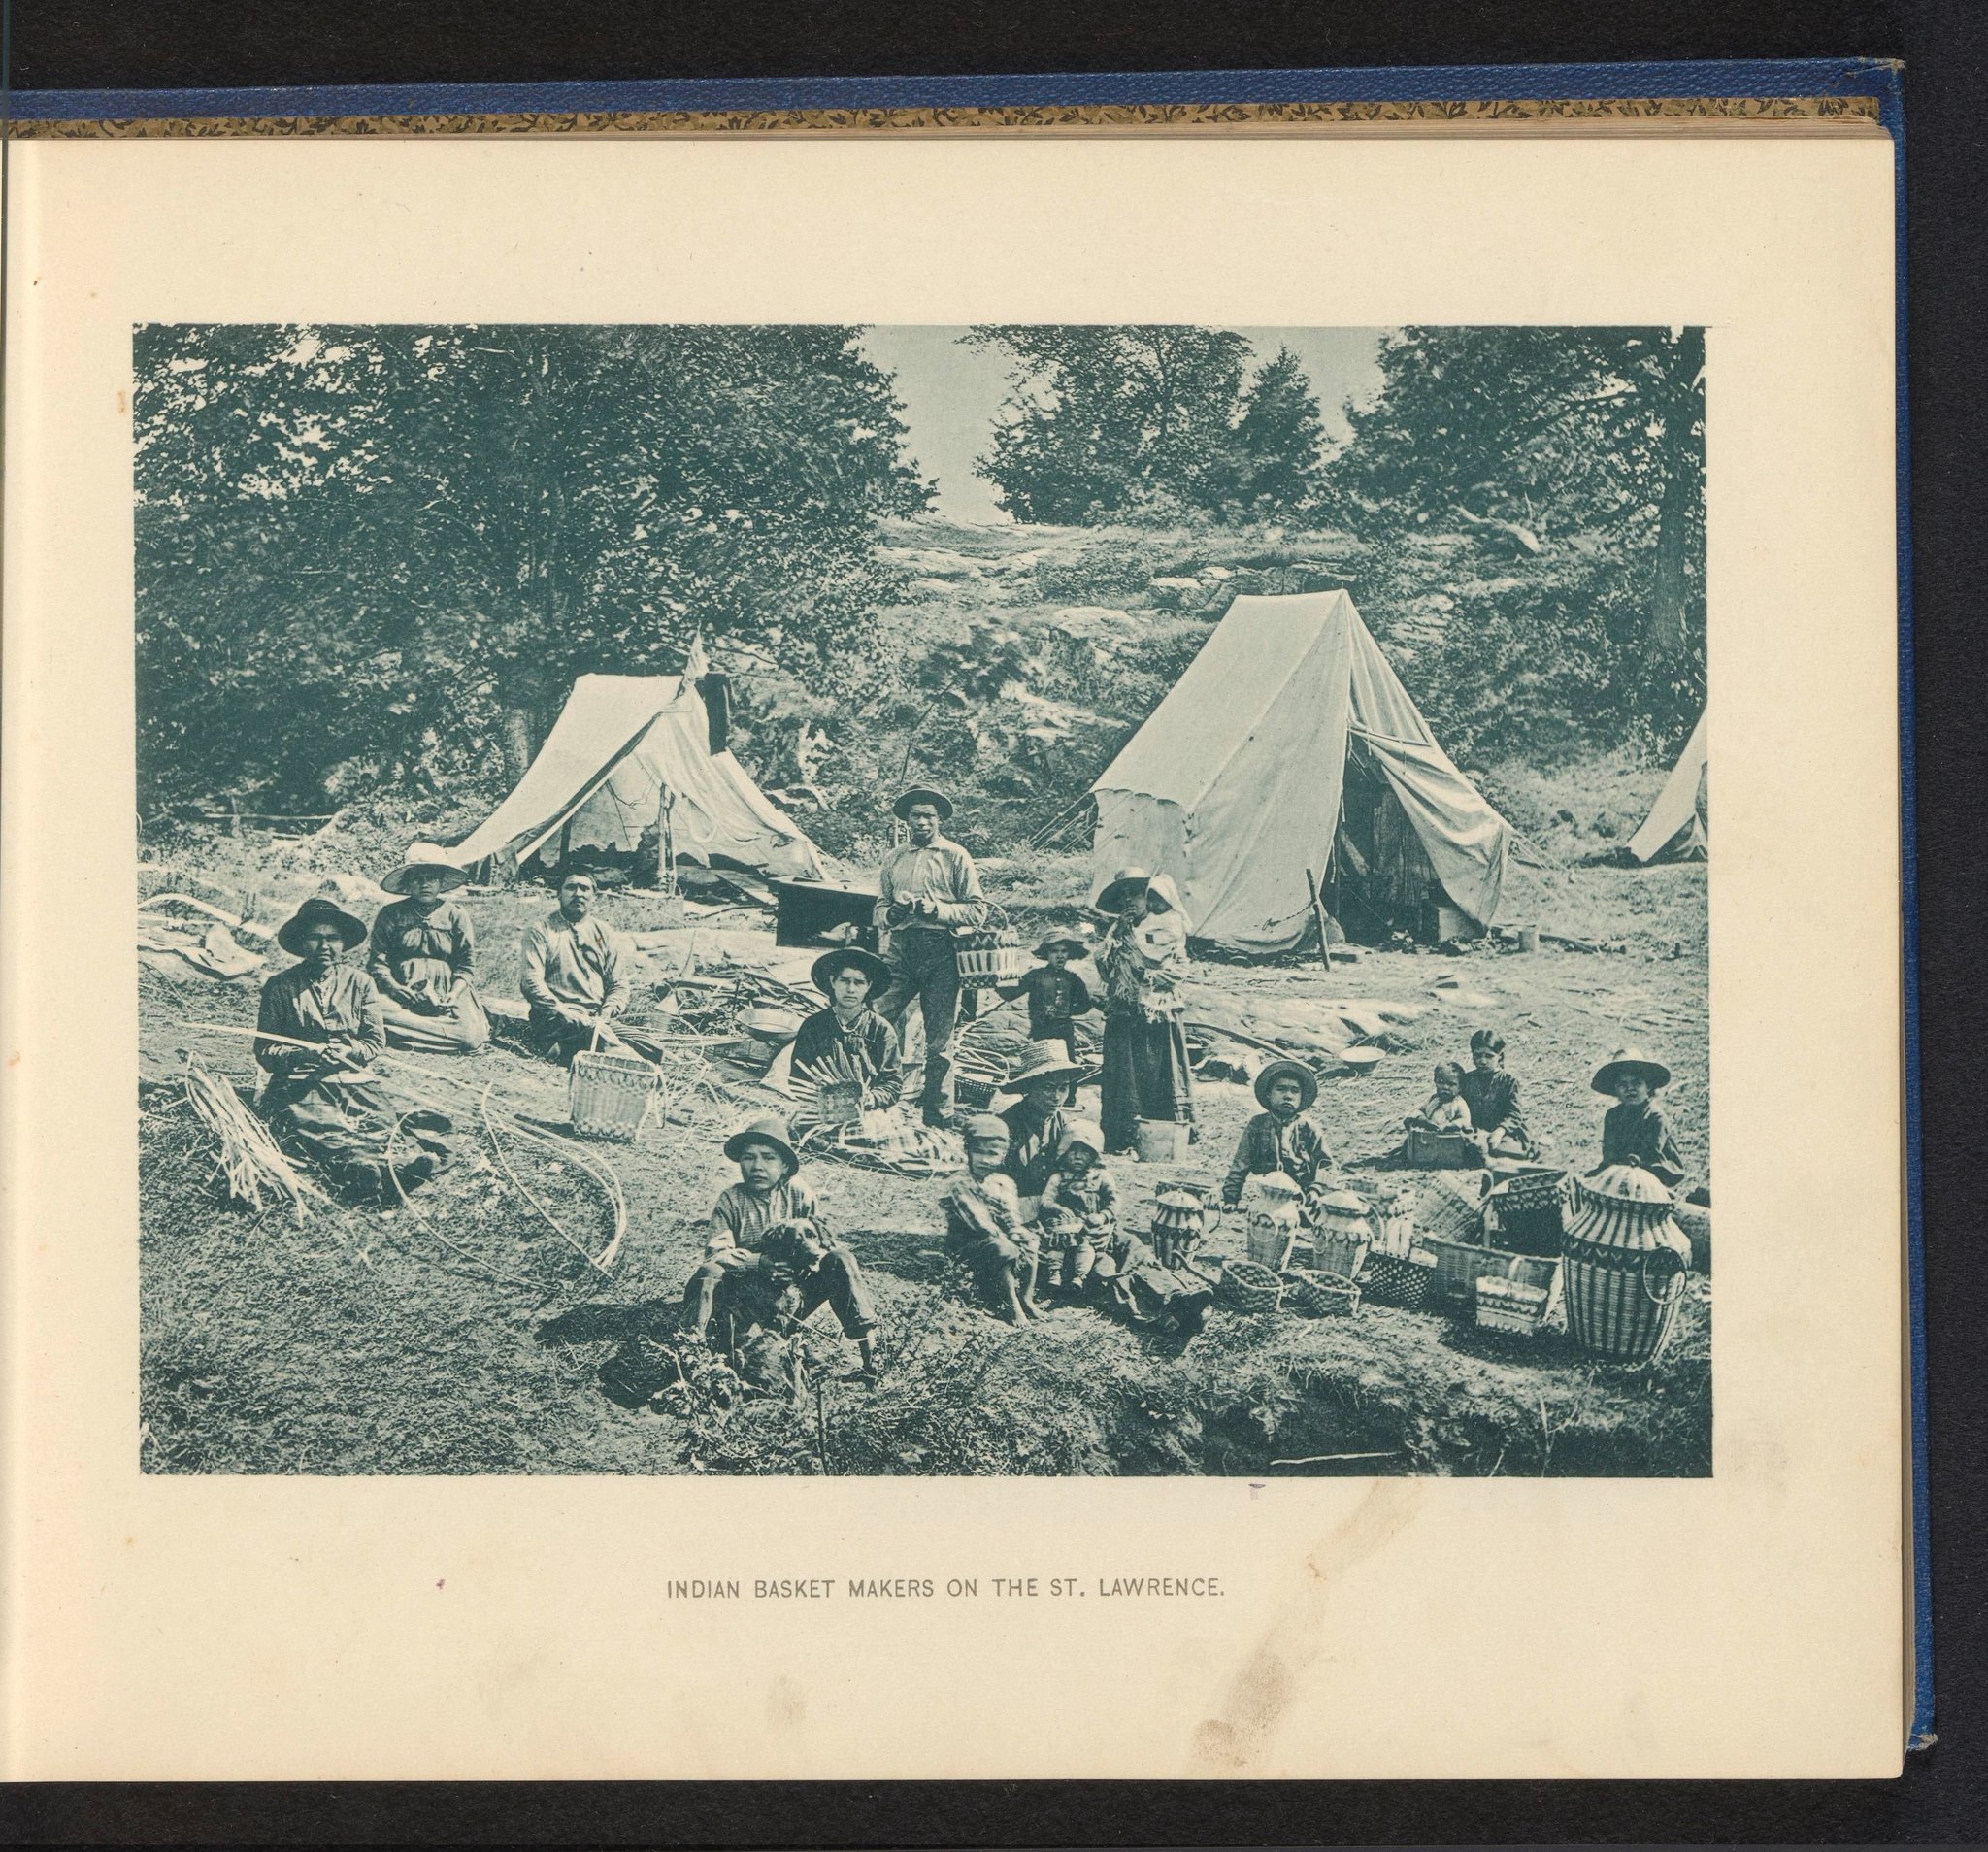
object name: page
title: Indianen die manden maken op de oever van de Saint Lawrence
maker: Anonymous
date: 1883-1893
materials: paper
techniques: photograph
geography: united states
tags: container made of plant material other than wood: basket, indigenous peoples of north america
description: Mannen, vrouwen en kinderen maken manden aan de oever van de rivier Saint Lawrence. Op de achtegrond enkele tenten. Mogelijk is dit een Huron- of Wendat-gemeenschap.